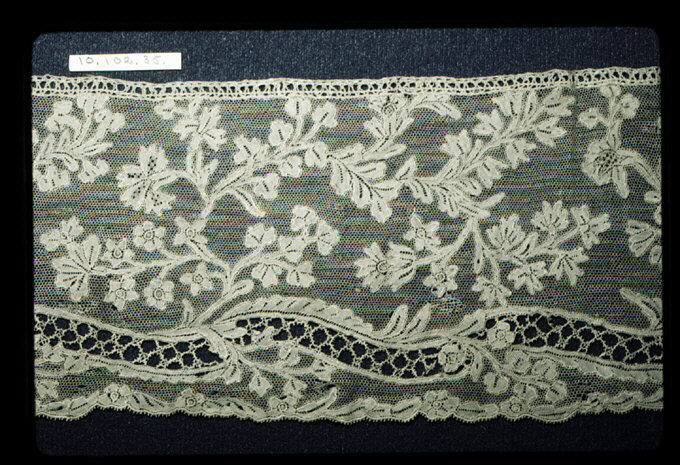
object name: cuff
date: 1701-1800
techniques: lace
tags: flowers